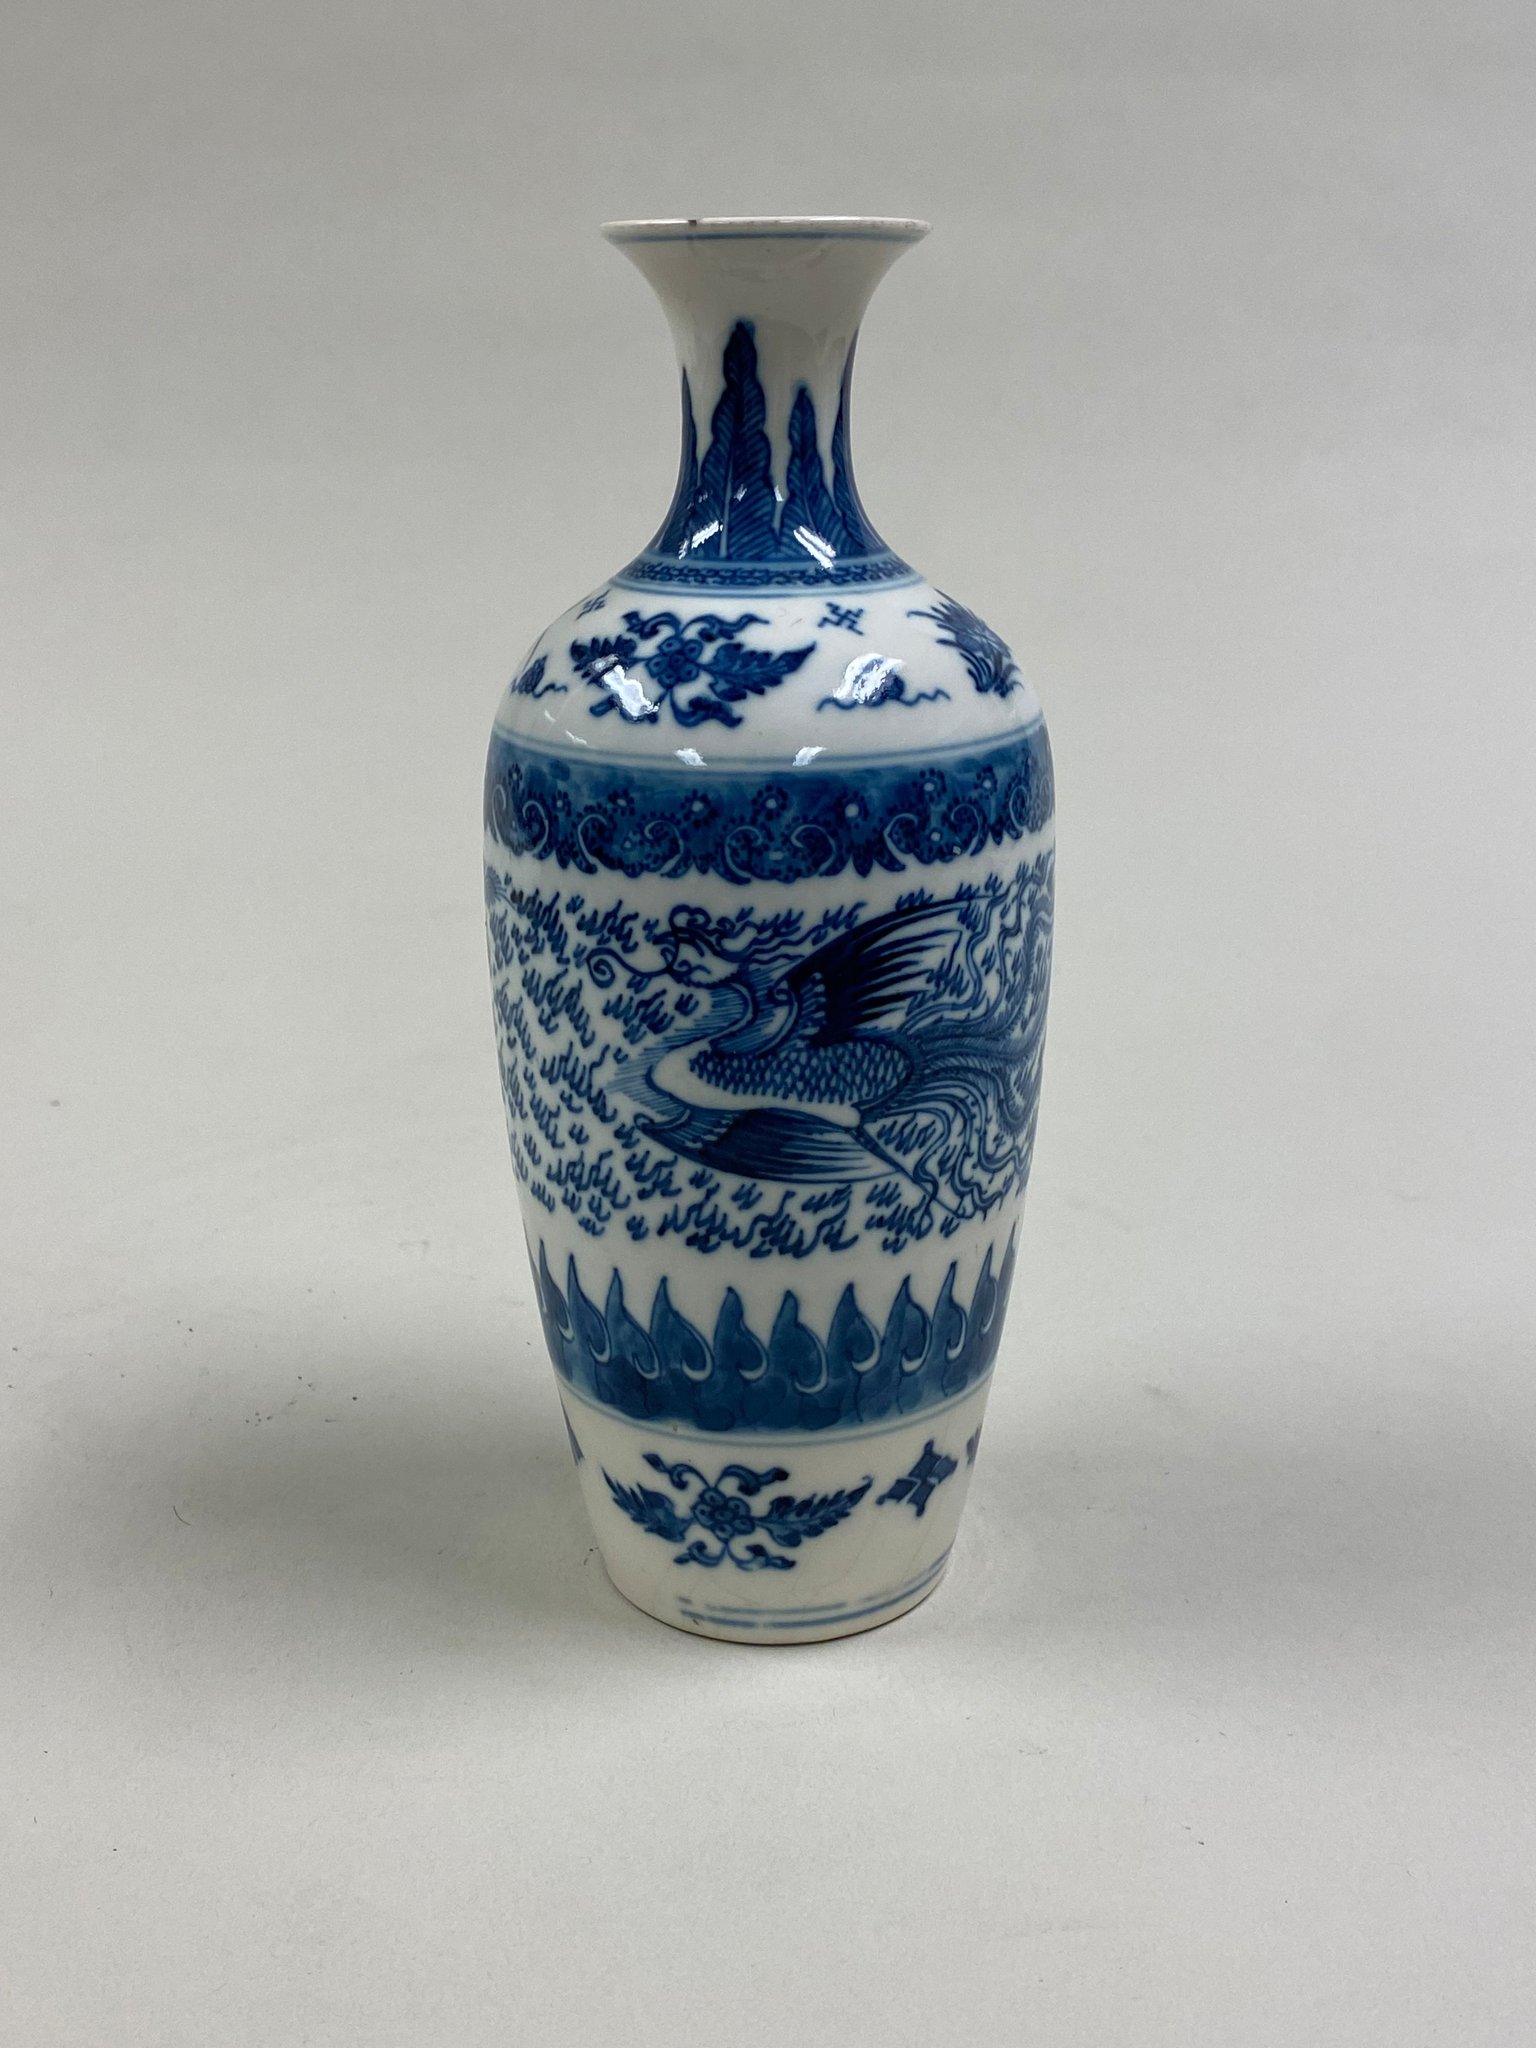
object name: vase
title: Vase with dragon and phoenix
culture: chinese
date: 1701-1733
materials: cobalt, soft paste porcelain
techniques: underglaze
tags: dragons,phoenix